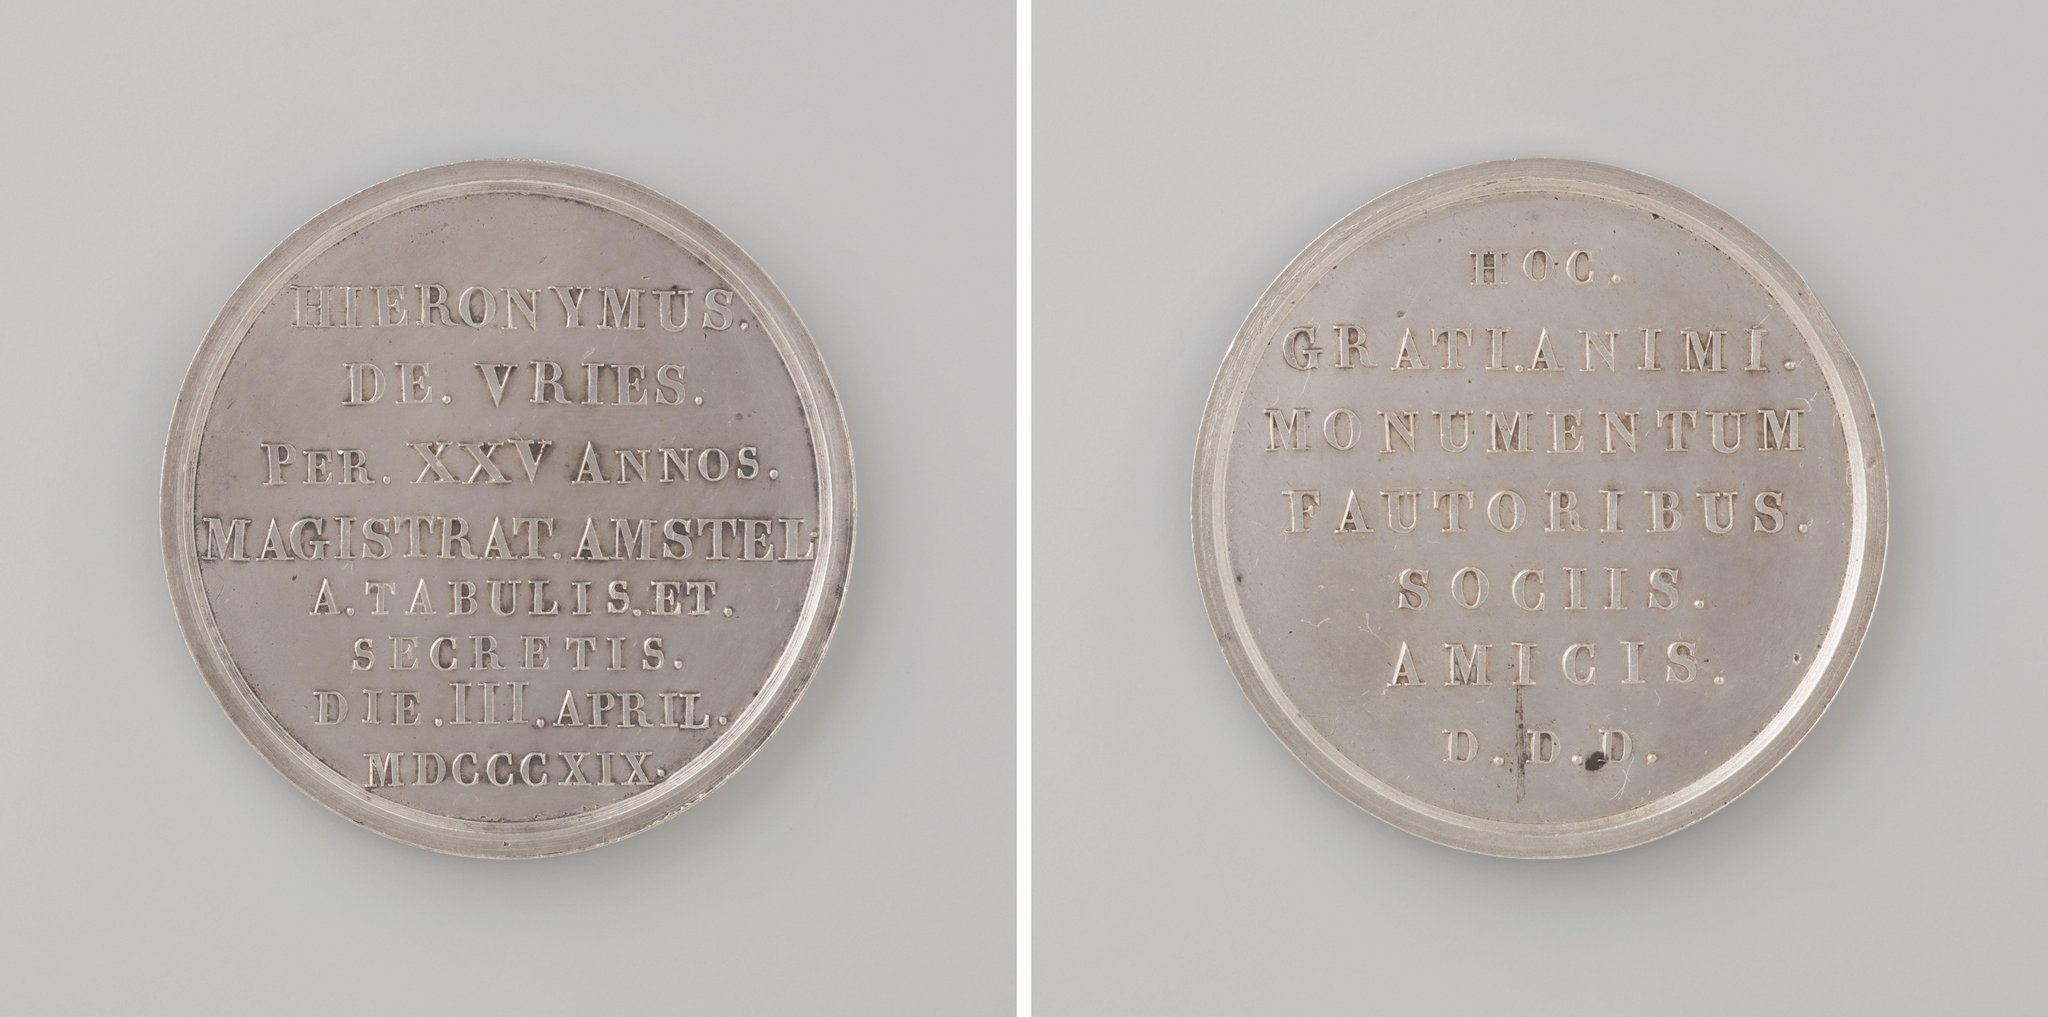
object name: history medal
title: Jeronimo de Vries, vijfentwintig jaar secretaris van de stad Amsterdam, penning door hem uitgedeeld onder begunstigers en vrienden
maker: Anonymous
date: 1819-1823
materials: silver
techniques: striking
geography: netherlands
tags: jeronimo de vries, amsterdam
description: Zilveren penning. Voorzijde: opschrift. Keerzijde: opschrift